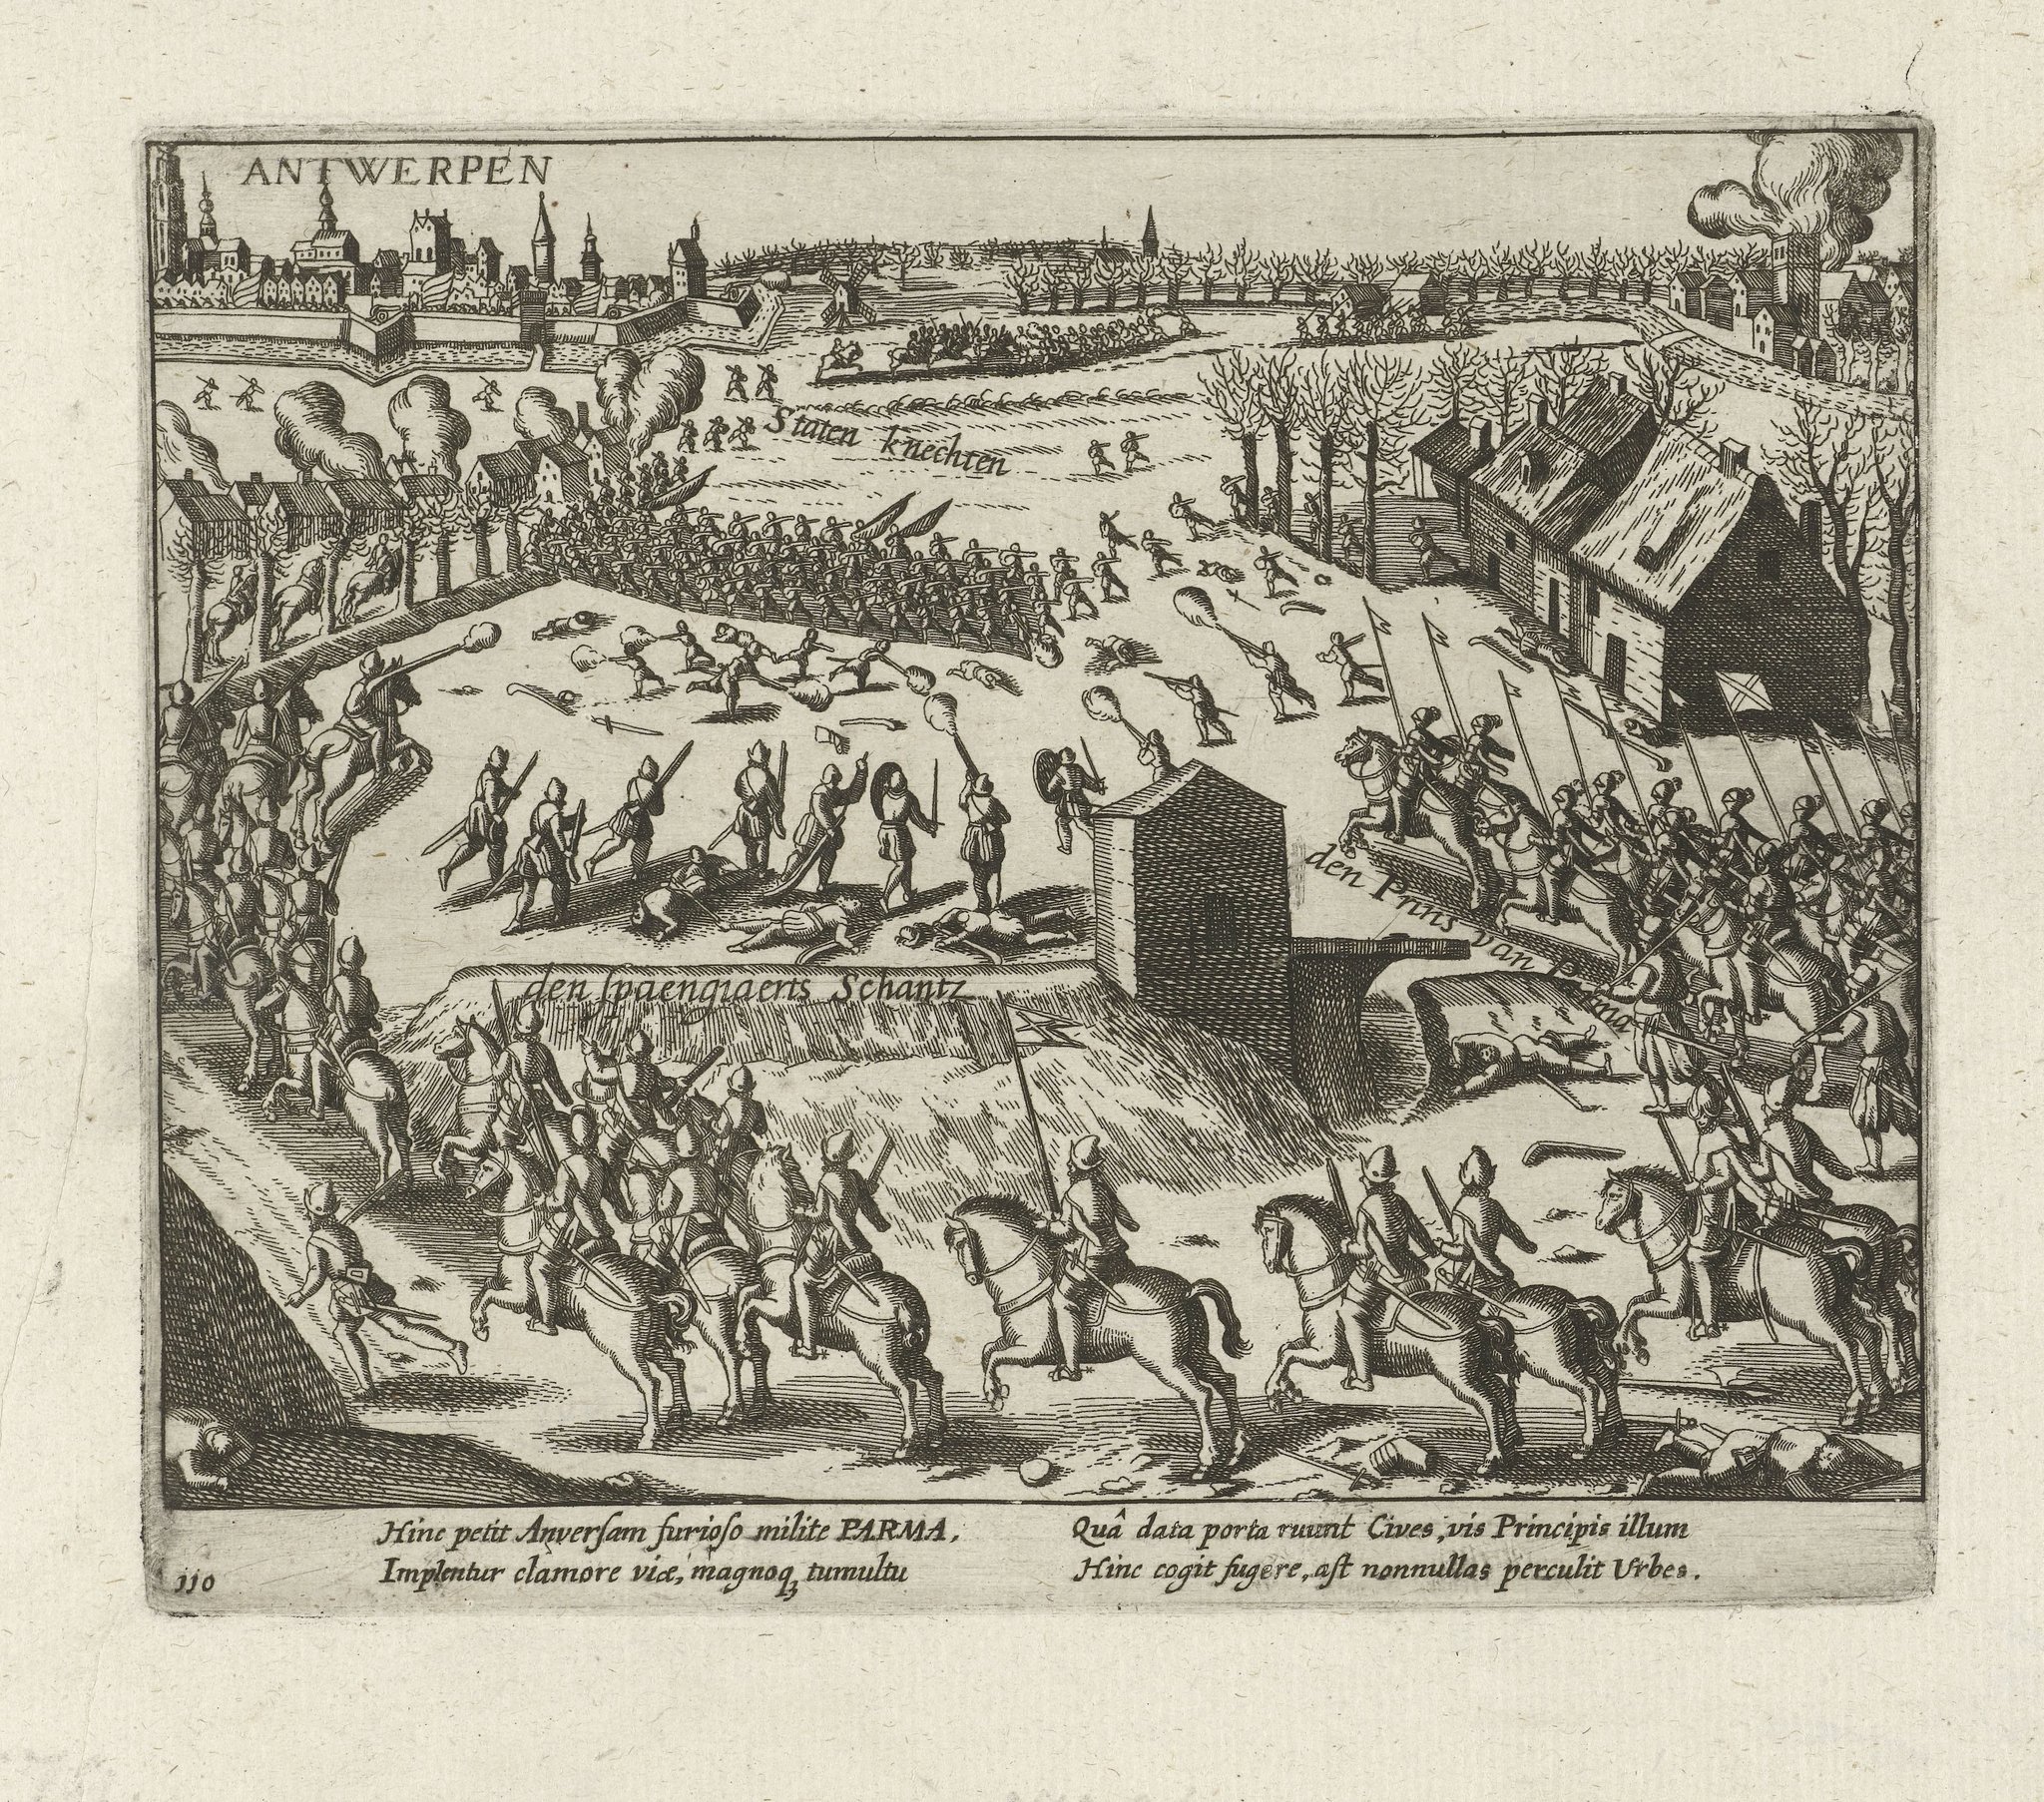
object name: history print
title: Slag bij Borgerhout, 1579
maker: Anonymous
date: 1613-1615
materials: paper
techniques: etching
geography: northern netherlands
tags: rome, alessandro farnese (landvoogd van de nederlanden en hertog van parma en piacenza), battle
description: Slag bij Borgerhout bij Antwerpen, 2 maart 1579, tussen het Staatse leger en het leger van de hertog van Parma. Op de voorgrond Spaanse ruiters en een Spaanse schans, links de brandende huizen van Borgerhout in de verte Antwerpen. Met onderschrift van 4 regels in het Latijn. Genummerd: 110. Onbedrukt op achterzijde.